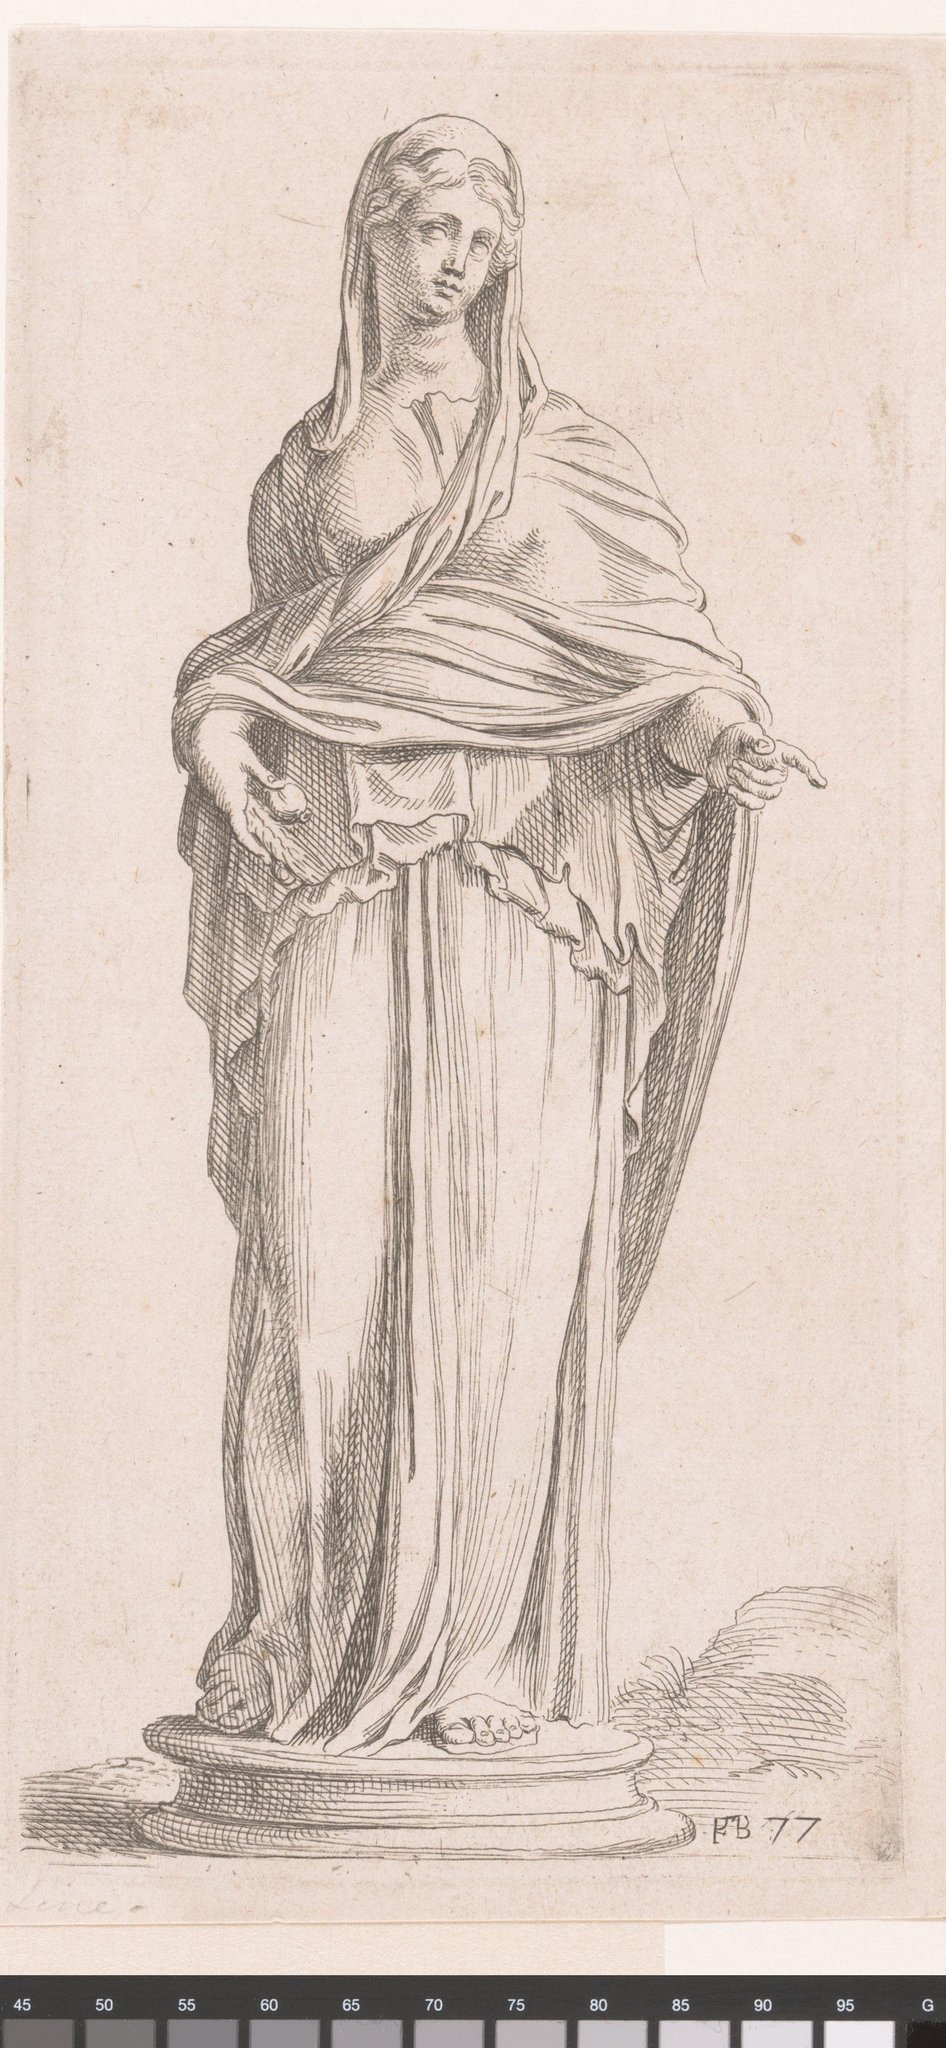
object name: print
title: Antieke standbeelden van Rome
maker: françois perrier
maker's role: draughtsman, painter, print maker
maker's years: 1594-1649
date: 1638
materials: paper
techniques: etching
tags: (story of) ceres (demeter), piece of sculpture, reproduction of a piece of sculpture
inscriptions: collector's mark: Lugt 2228